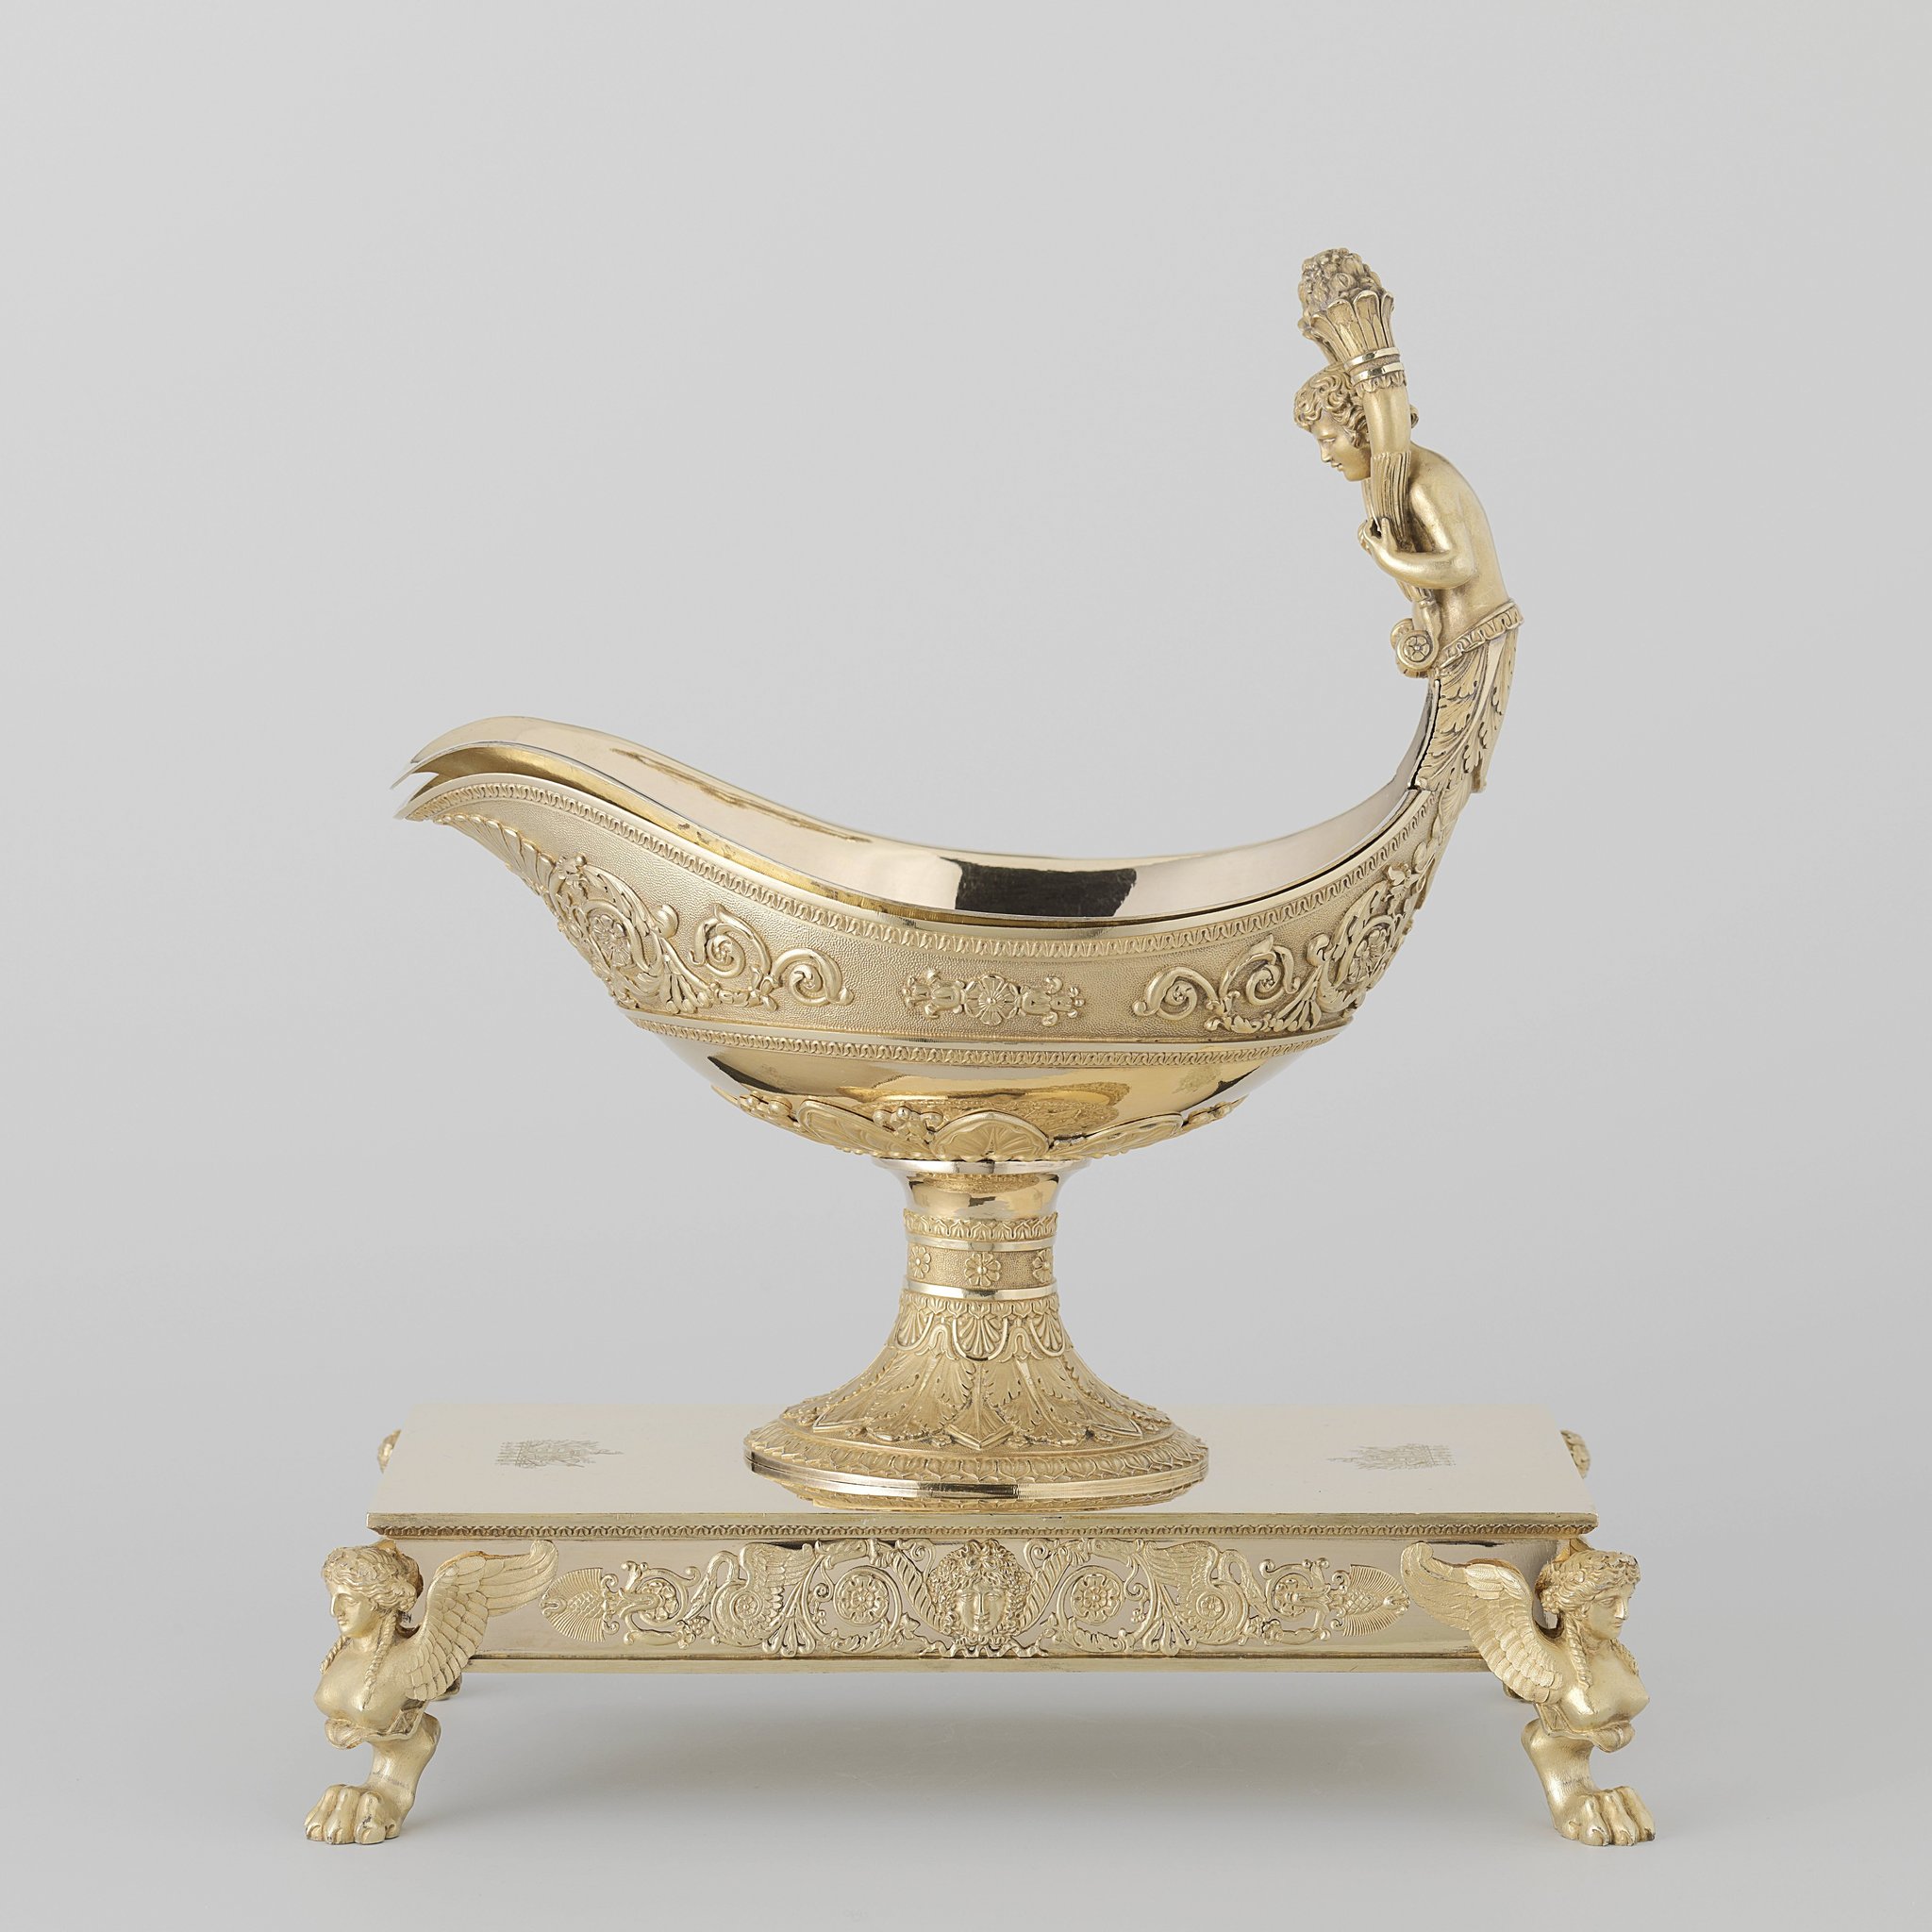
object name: sauceboat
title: Dish covers, coolers, soup tureens, salt cellars, pepper and mustard pots, sauceboats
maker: jean baptiste claude odiot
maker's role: jeweler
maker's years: 1763-1850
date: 1819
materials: silver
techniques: gilding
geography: paris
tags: 'cornucopia', horn of plenty, sphinx (lion/woman); 'sfinge' (ripa), ornament derived from plant forms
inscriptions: alloy mark, countermark, retailer's mark, maker's mark, duty mark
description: These items are part of an 140-piece service that belonged to Alexandra Vasilievna Engelhardt, a noblewoman at the Russian court. The renowned silversmith Odiot collaborated with the painter Prud’hon and the architect Cavelier. They proudly presented their models at the French national crafts exhibition in 1819. The large late Empire figures, like the kneeling angels supporting the soup tureen, are striking.